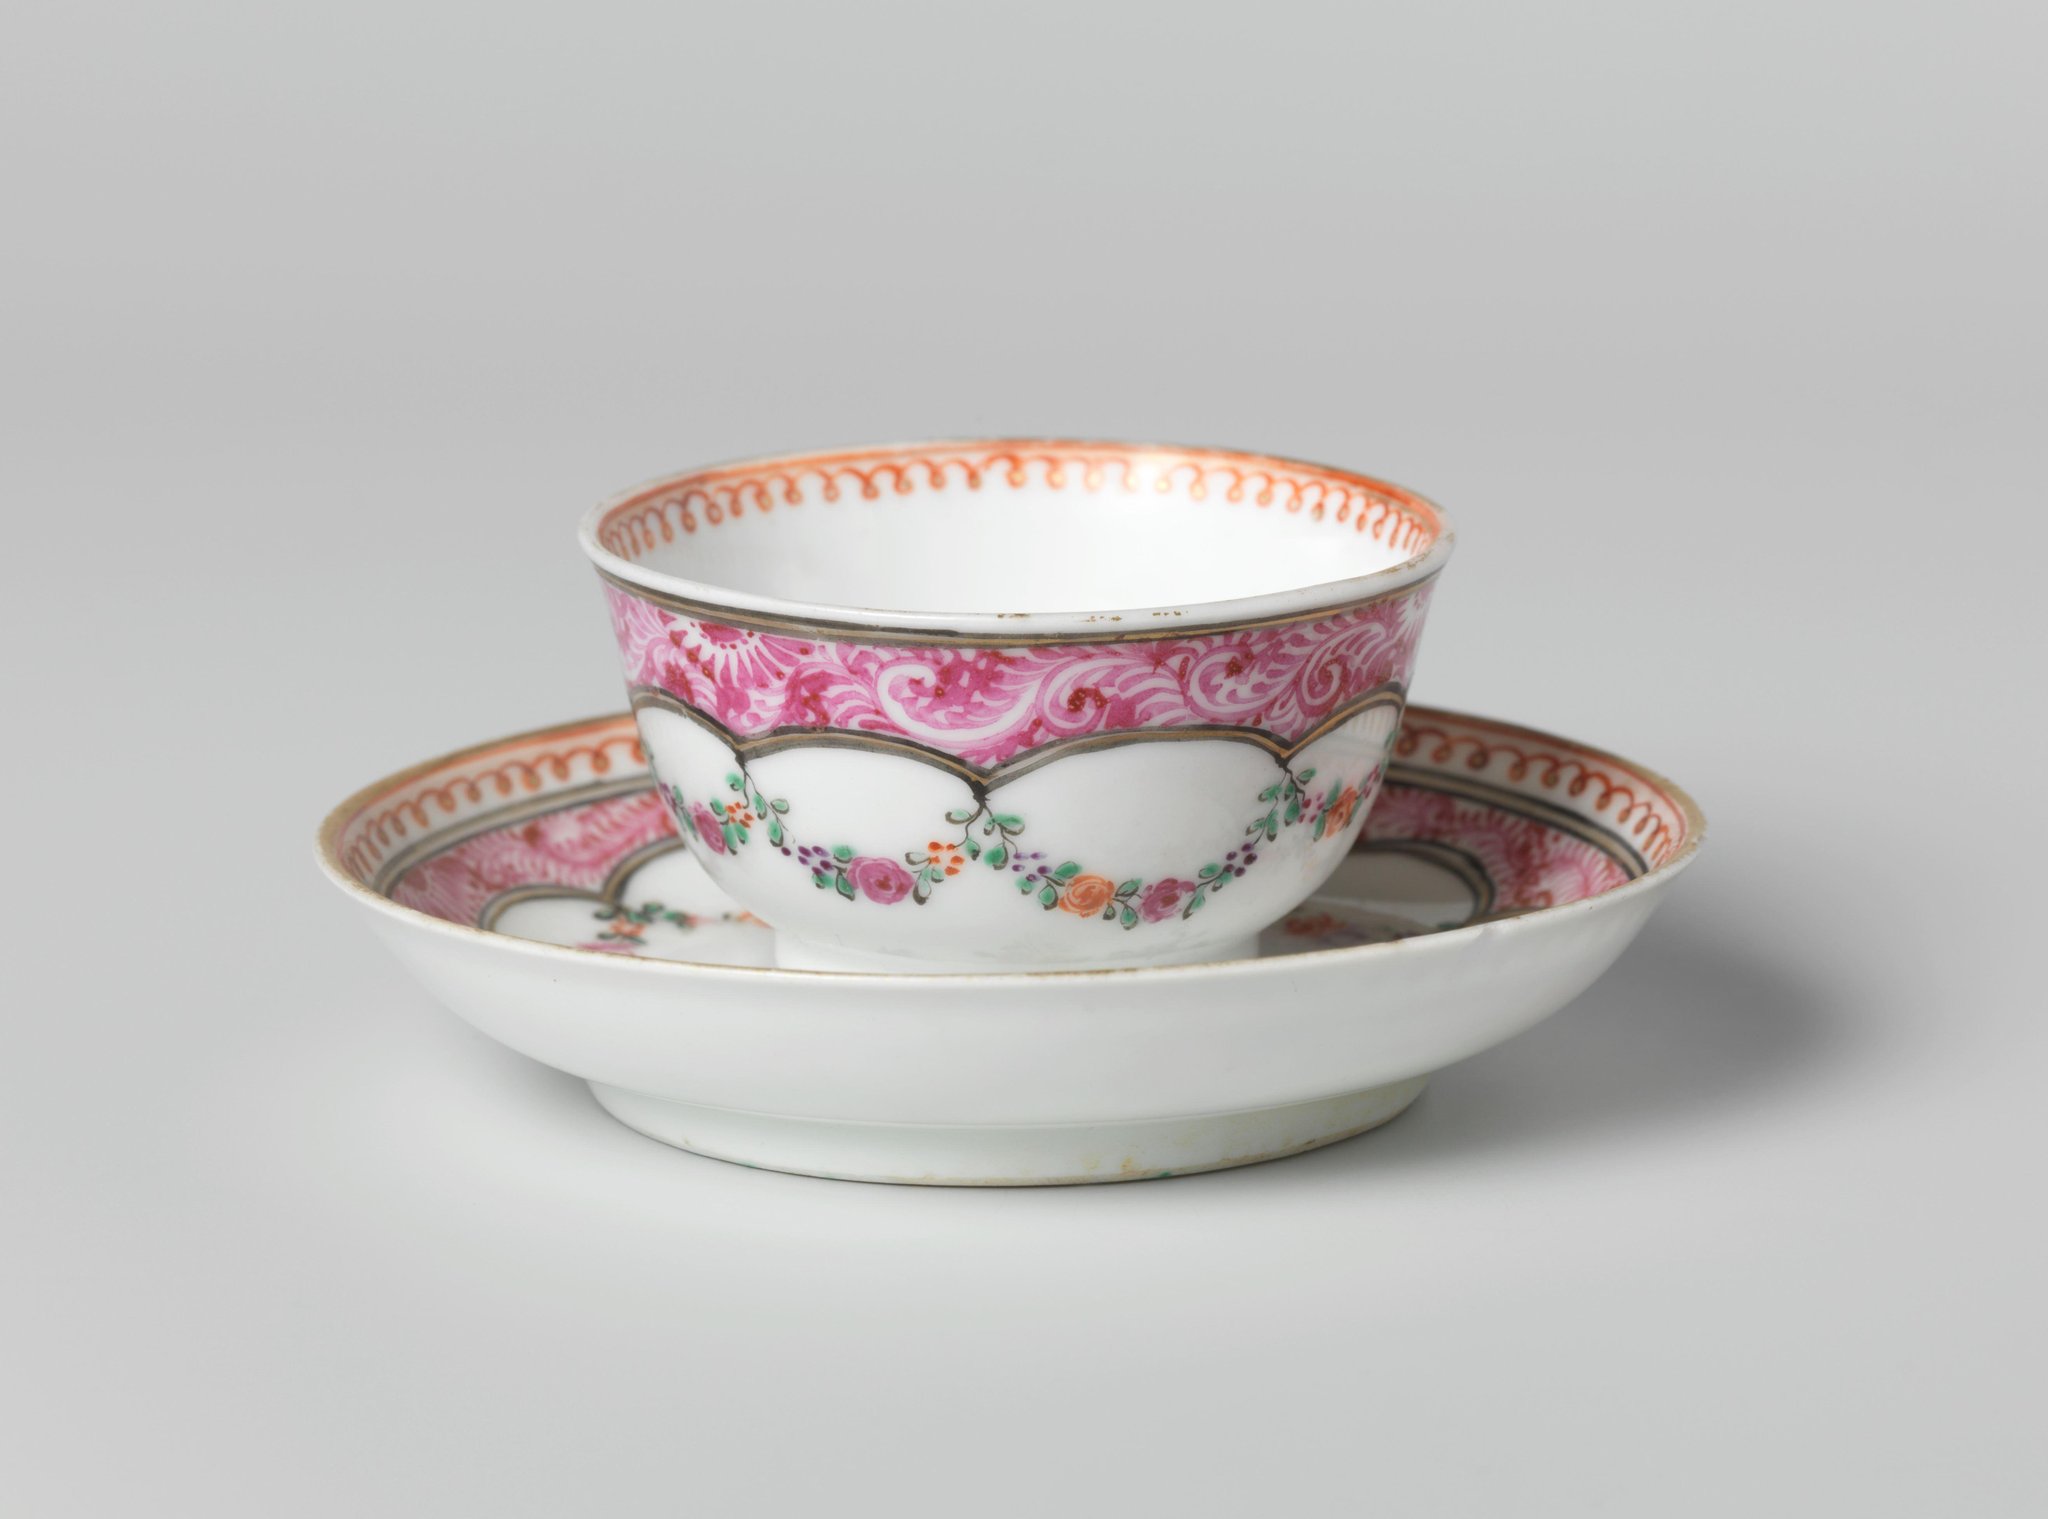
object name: kop en schotel, kop en schotel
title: Bell-shaped cup and saucer with a flower group and garlands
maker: Anonymous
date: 1750-1774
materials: glaze, gold, paint, porcelain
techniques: firing, gilding, turning, vitrification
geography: china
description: Kop en schotel versierd in kleuren met bloemguirlandes.